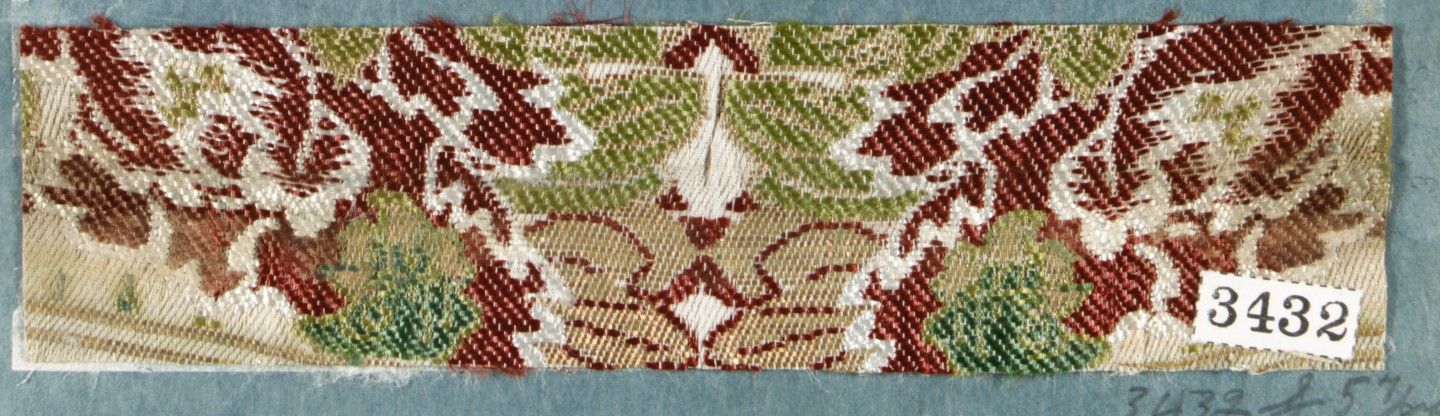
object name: textile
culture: japanese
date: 1801-1900